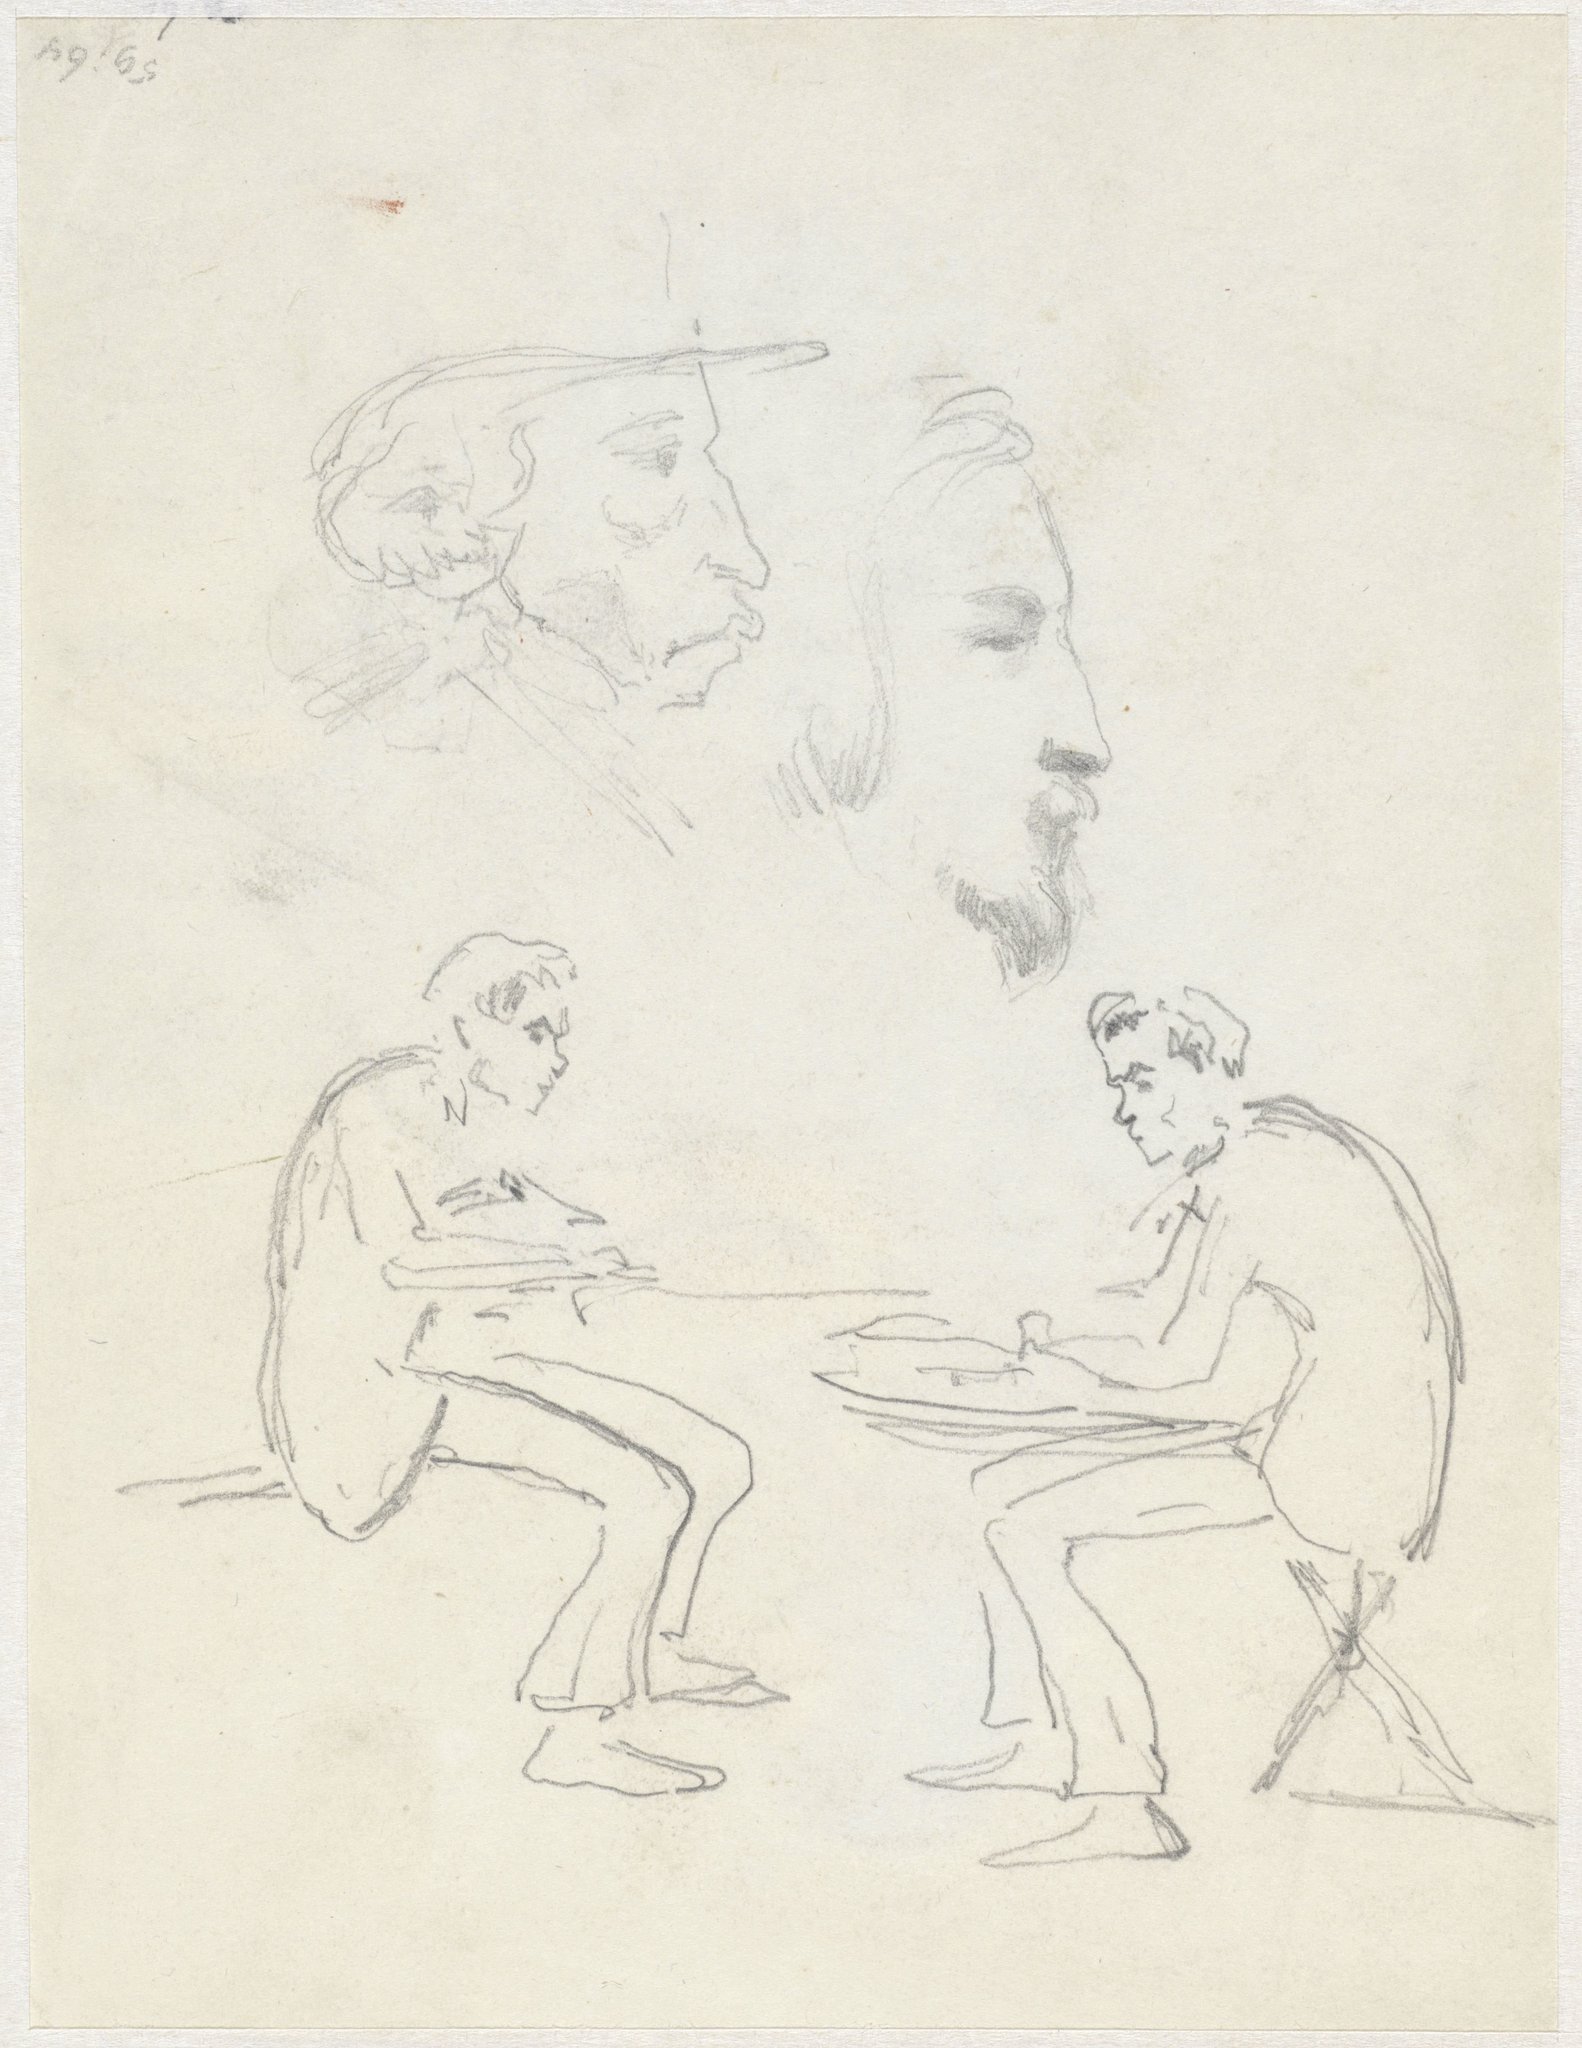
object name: drawing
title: Studie van twee zittende mannen en twee mannenkoppen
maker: johan daniël koelman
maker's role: draughtsman, print maker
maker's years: 1831-1857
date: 1841-1857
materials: paper, pencil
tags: head (human), sitting figure